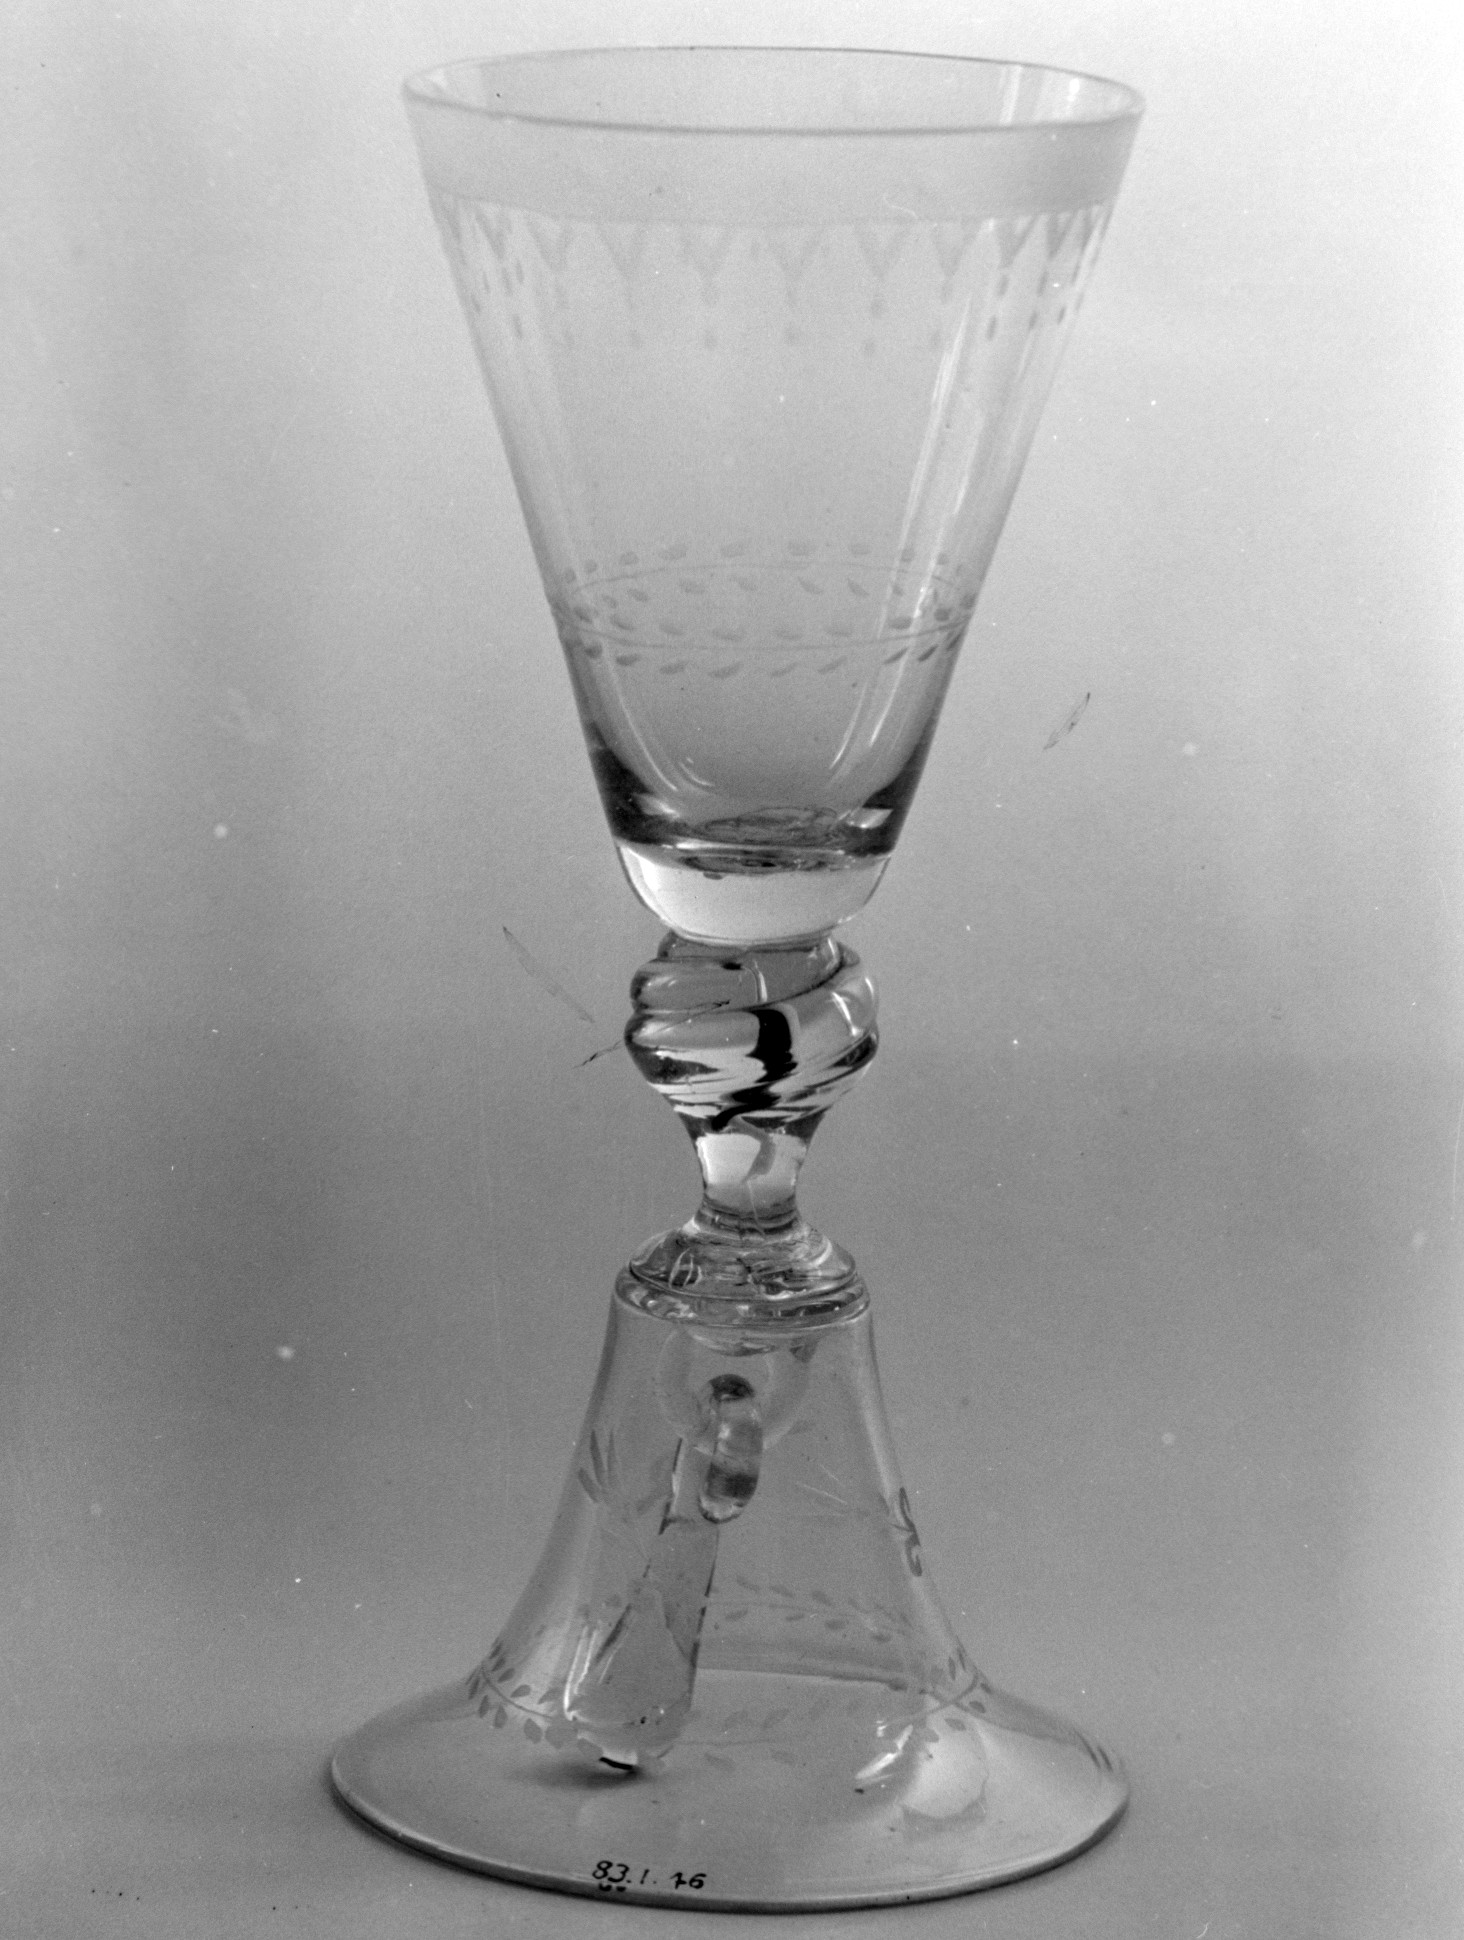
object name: goblet with bell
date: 1750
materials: glass